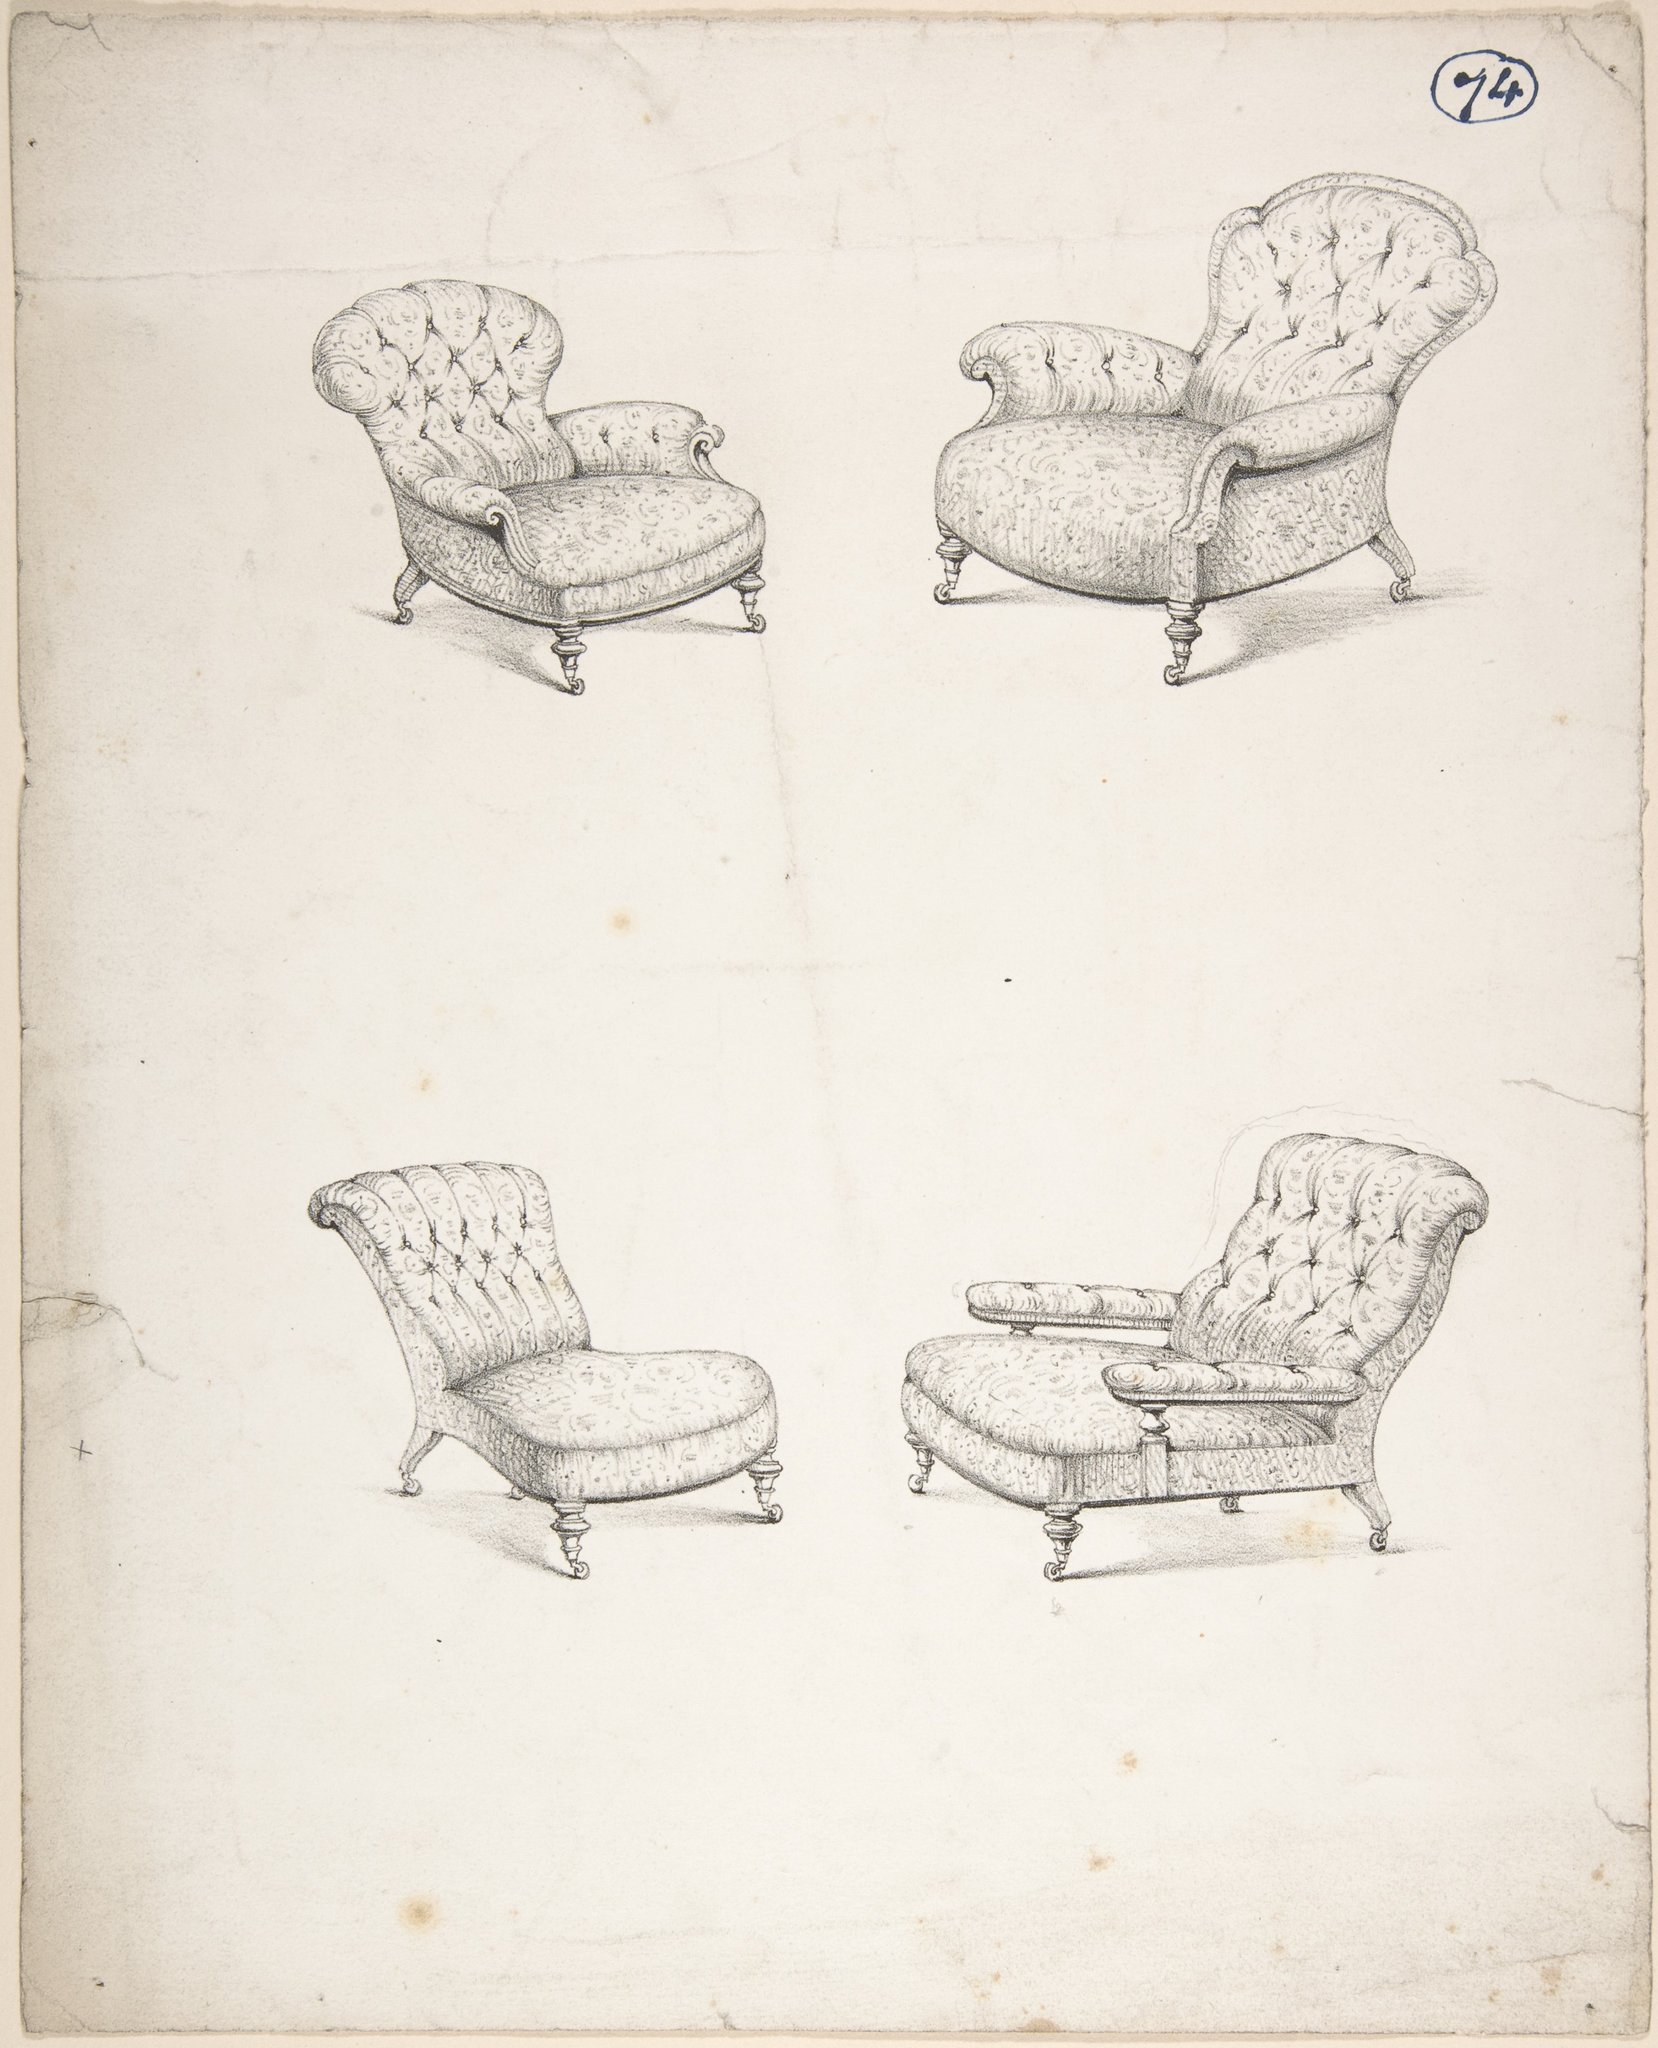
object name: drawing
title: Designs for Four Upholstered Chairs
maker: charles hindley and sons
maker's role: artist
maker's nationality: british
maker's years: 1841-1917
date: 1841-1884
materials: chalk, graphite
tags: chairs